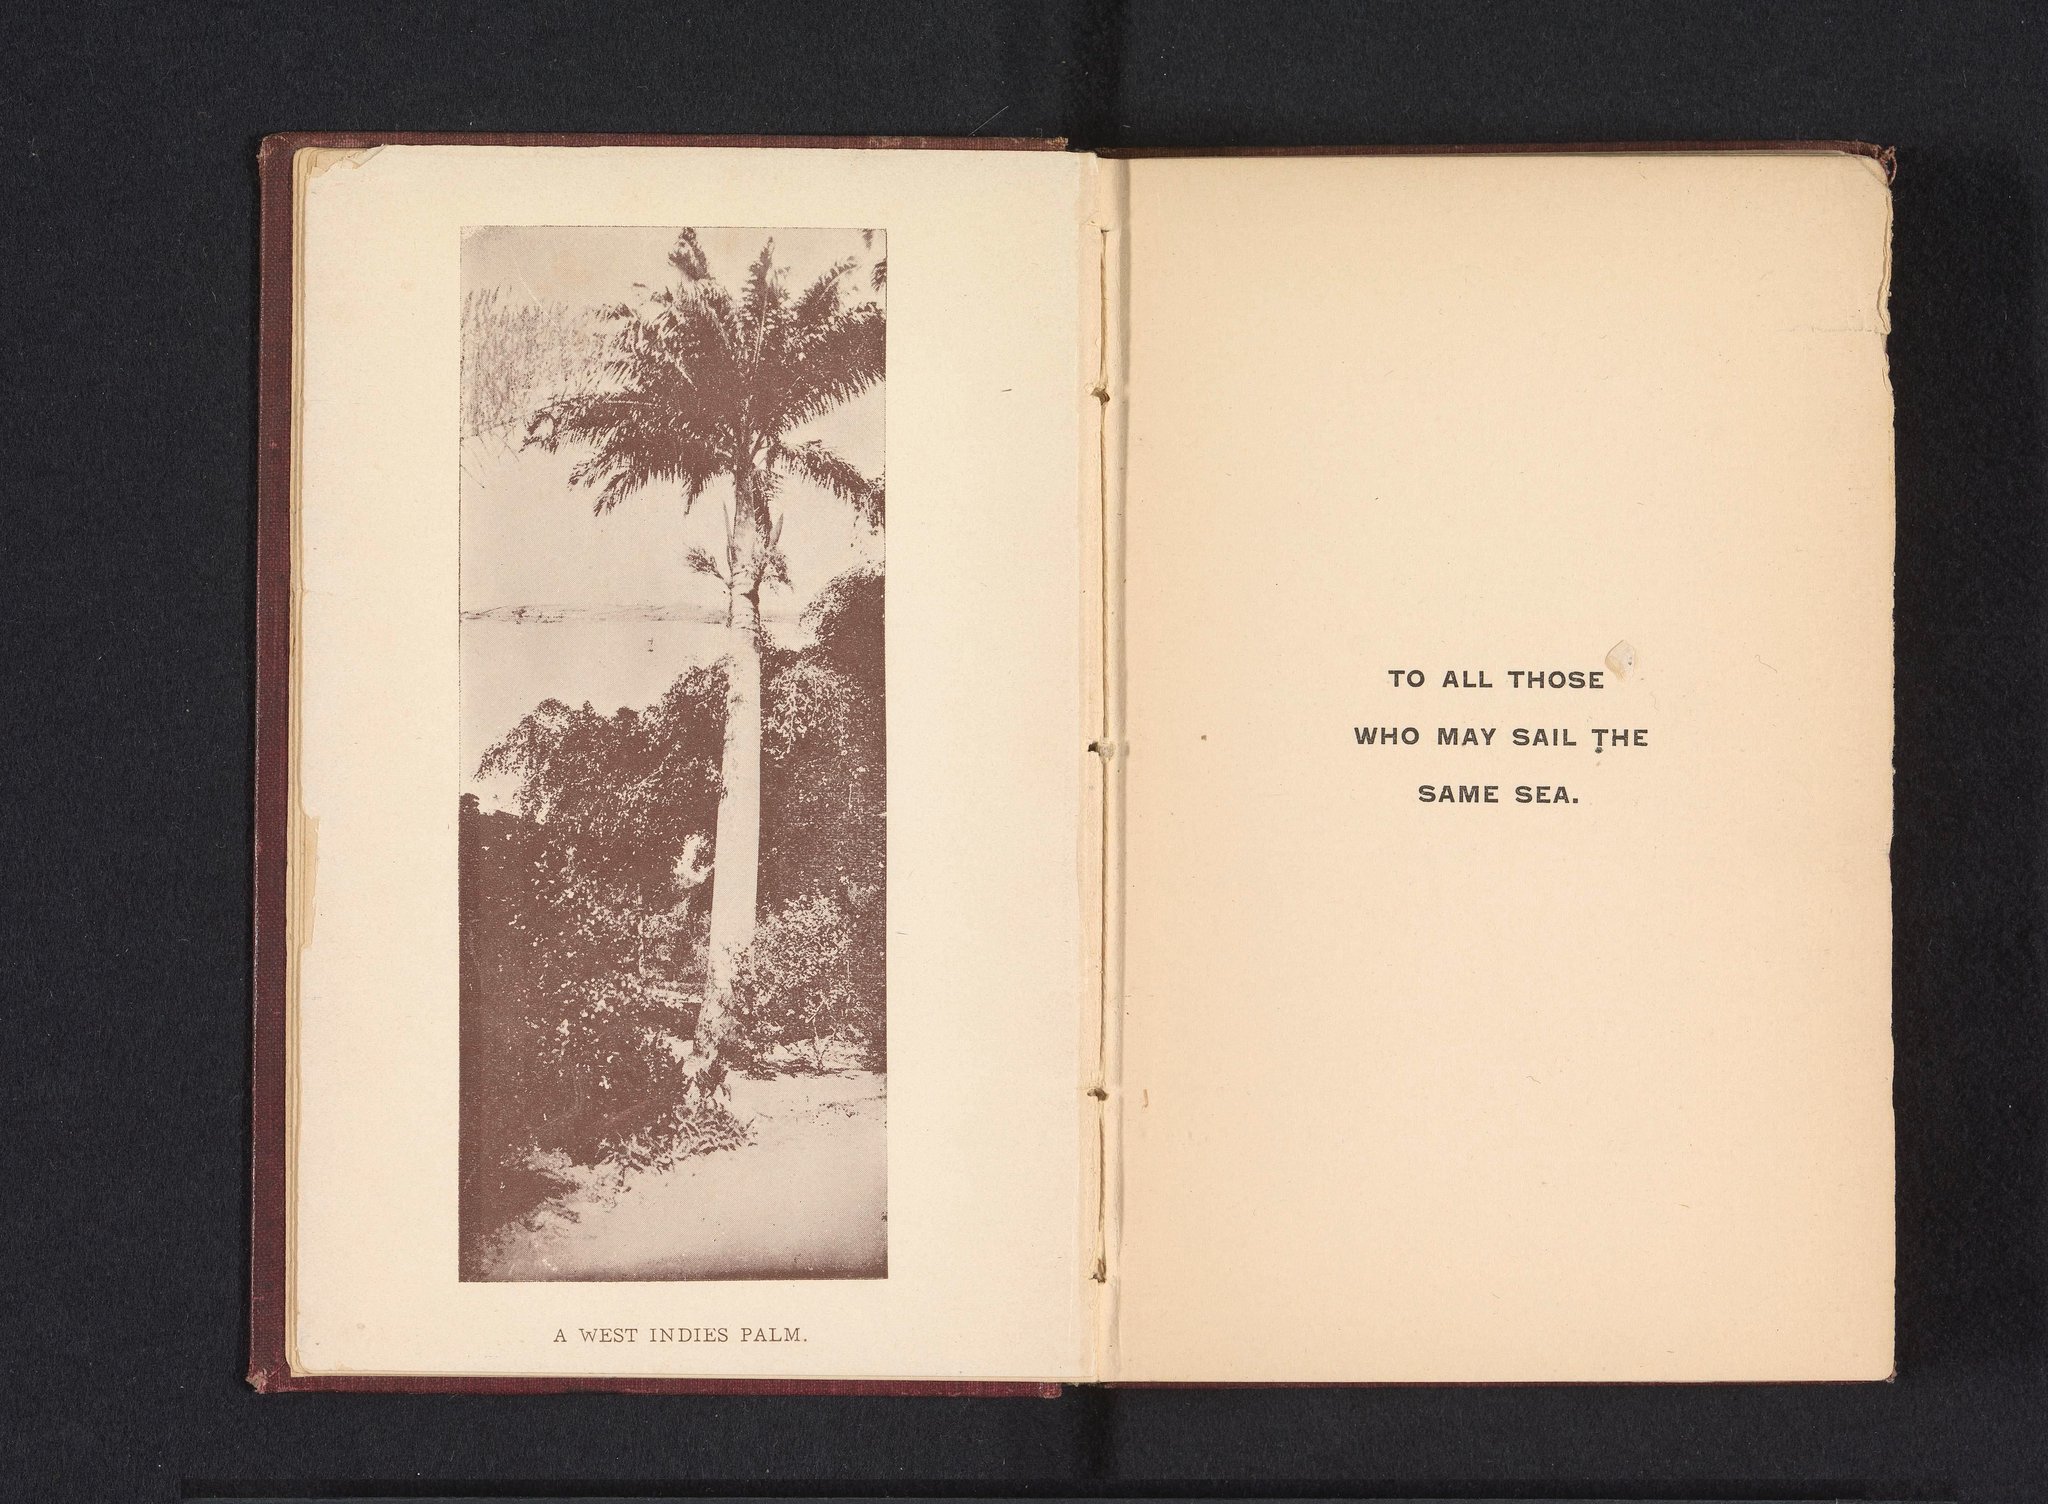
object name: photomechanical print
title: A West Indies palm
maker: Anonymous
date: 1892-1902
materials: paper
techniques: autotype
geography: caribbean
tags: trees: palm-tree